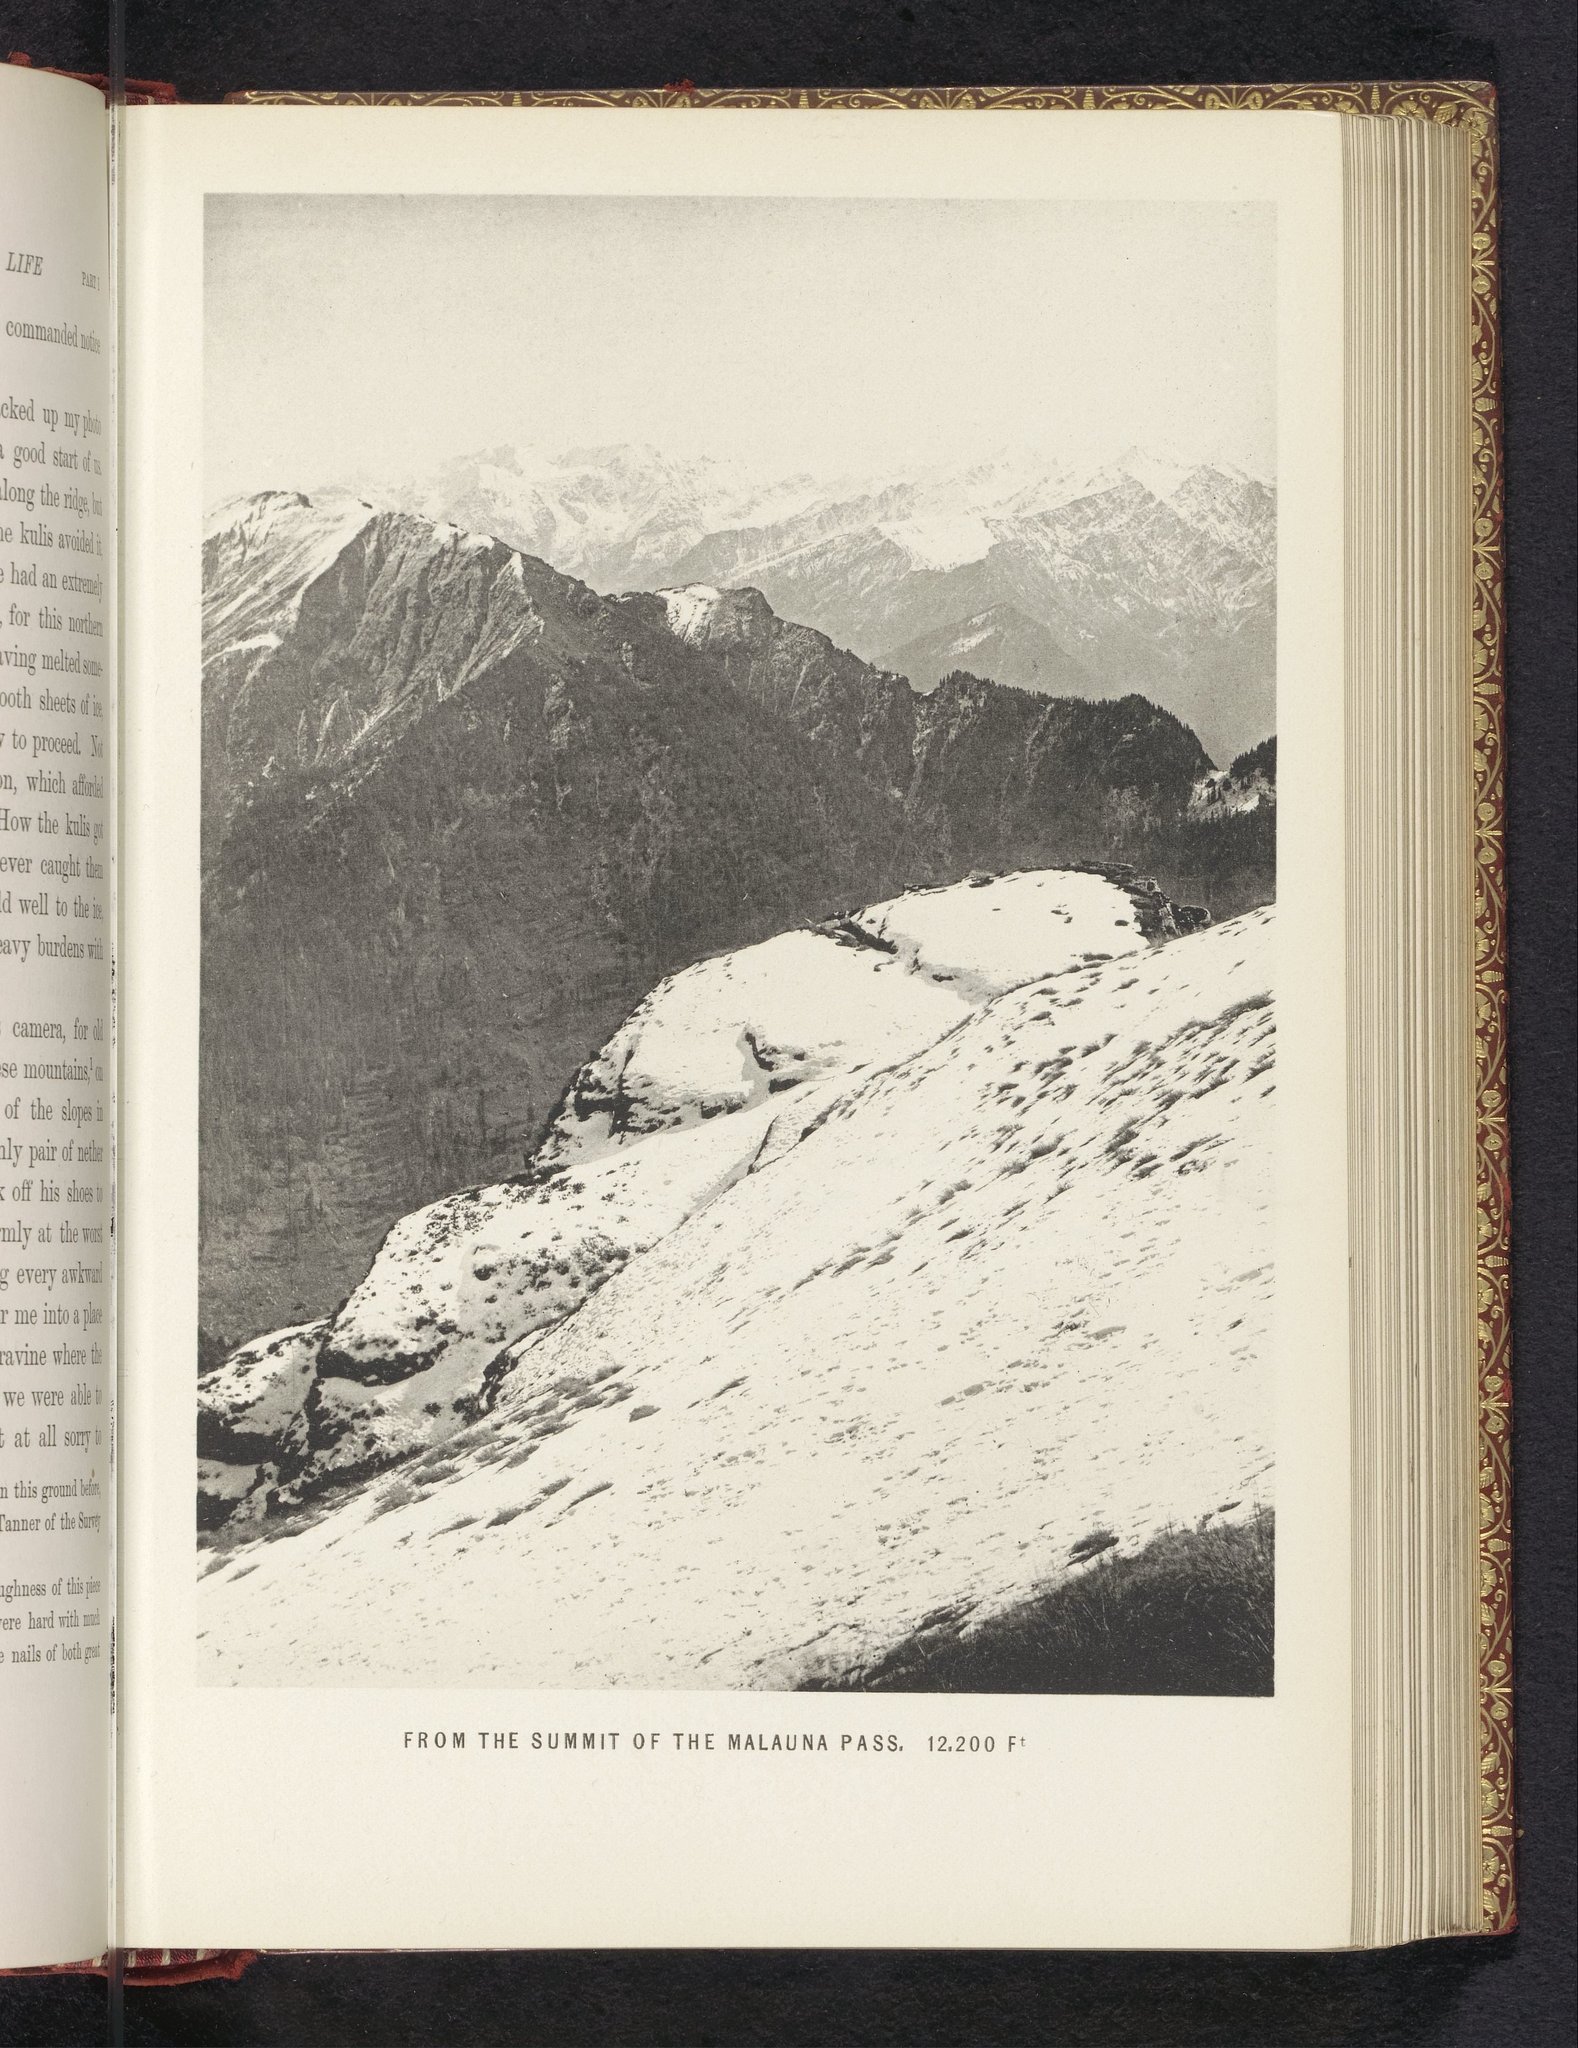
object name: page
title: View from the summit of the Malana pass, Himachal Pradesh, India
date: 1890-1895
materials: paper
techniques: photograph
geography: malana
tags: mountain-range, snow peaks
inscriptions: caption: ‘FROM THE SUMMIT OF THE MALAUNA PASS. 12.200 Ft’